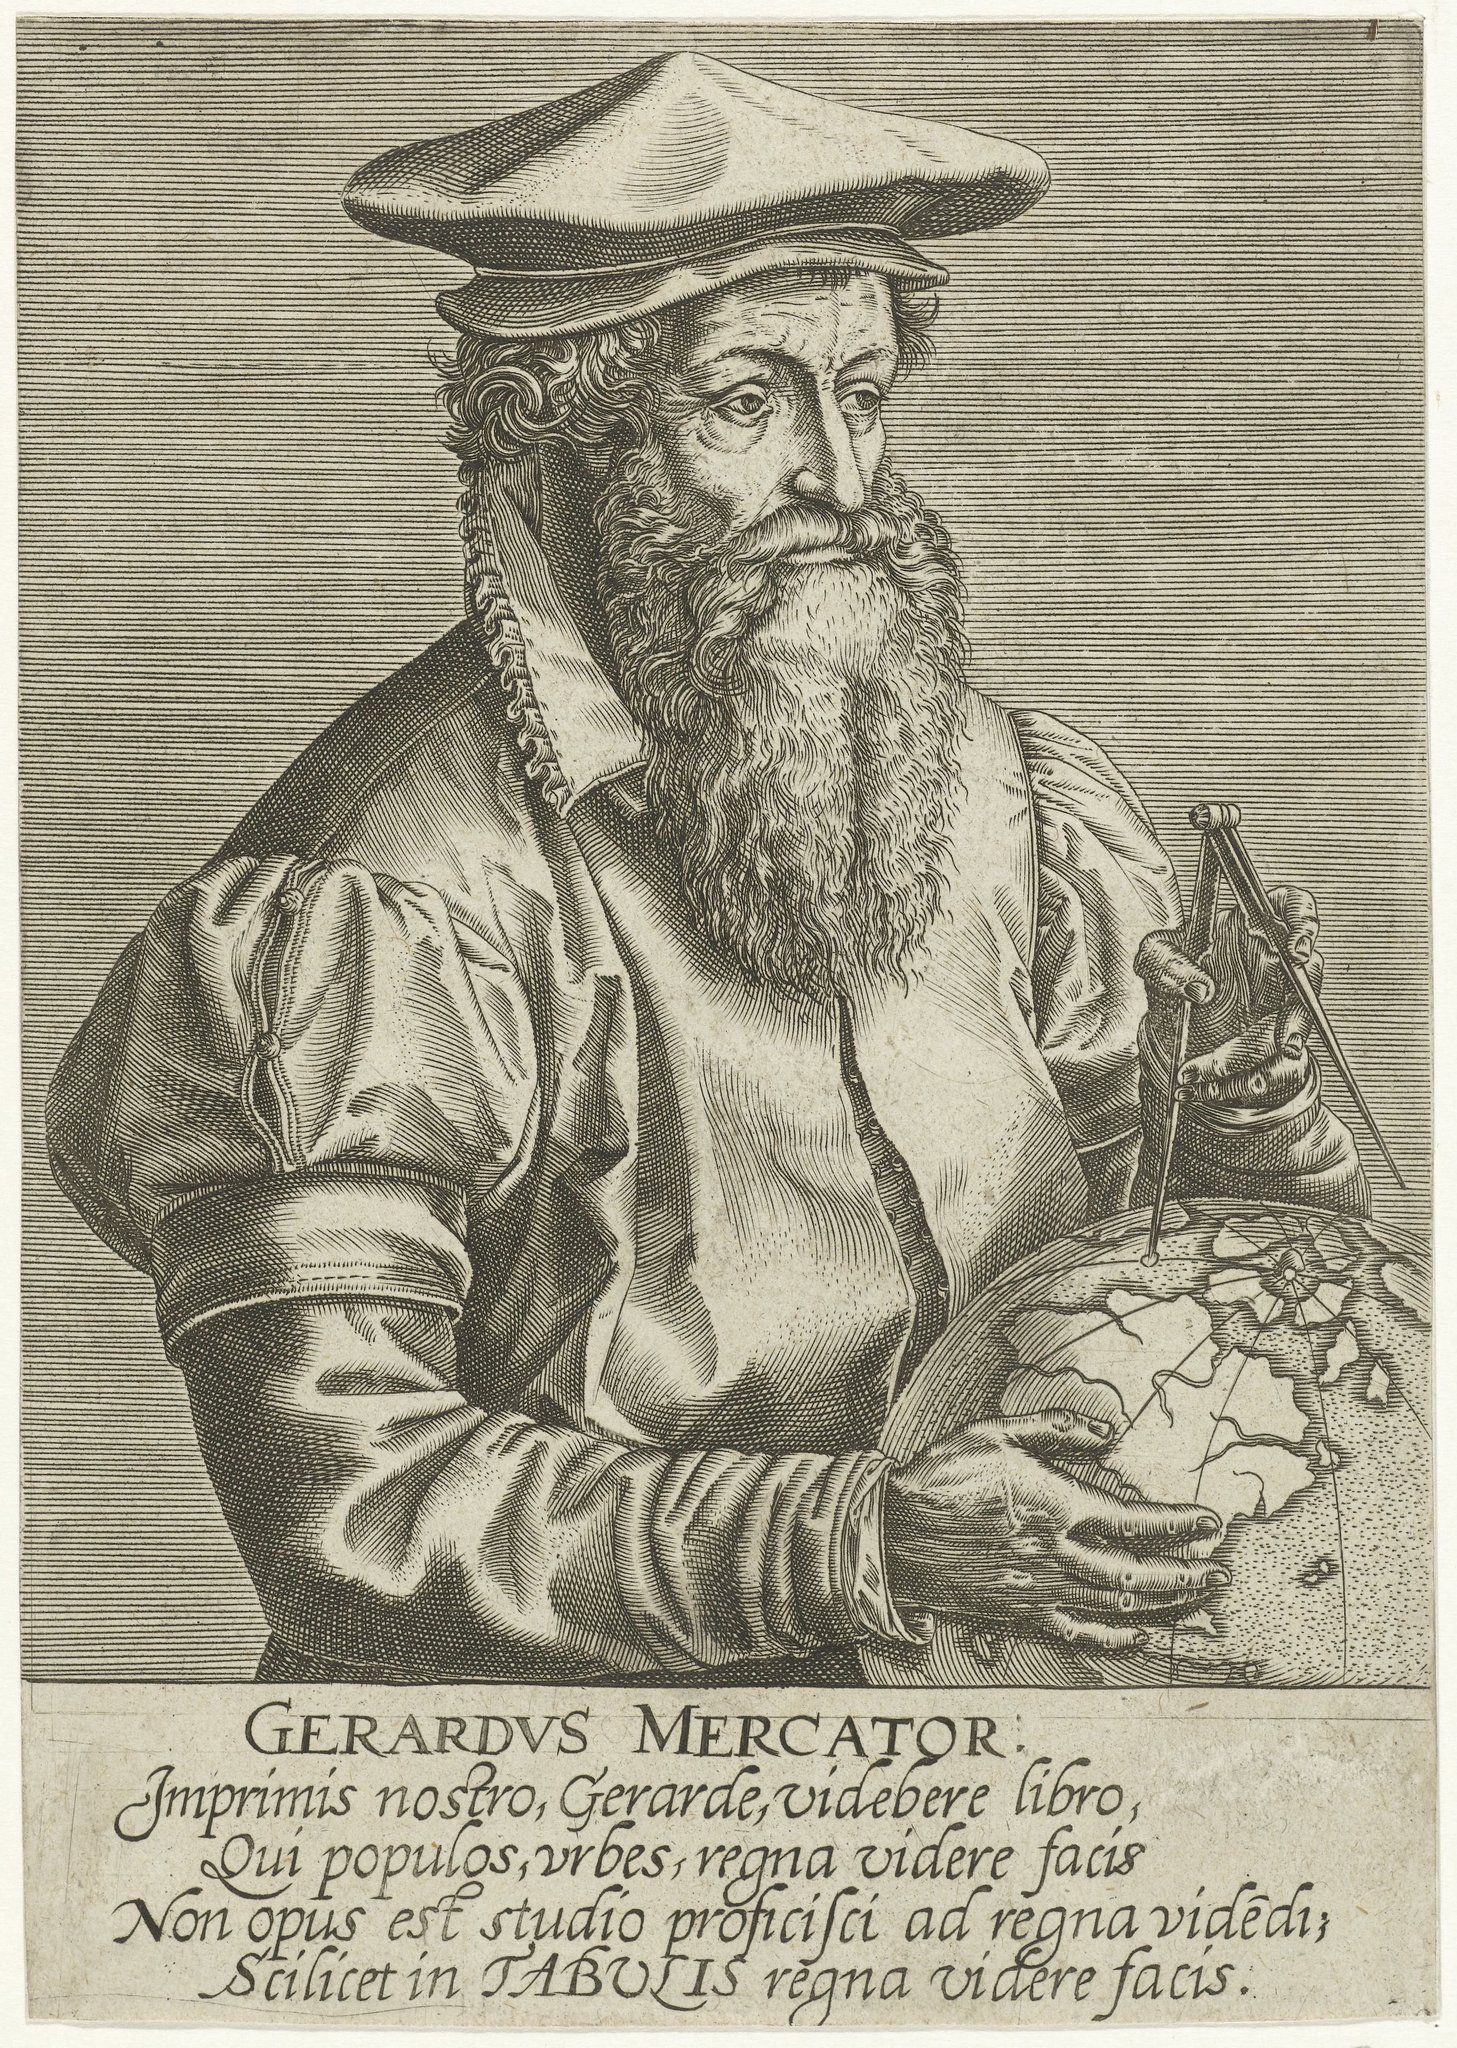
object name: print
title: Portret van Gerardus Mercator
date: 1587-1606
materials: paper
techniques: engraving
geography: antwerp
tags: gerardus mercator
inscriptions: collector's mark: Lugt 2228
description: Portret van Gerardus Mercator, beroemde cartograaf uit Rupelmonde. Buste naar rechts. In zijn handen een wereldglobe en een passer. De prent heeft een Latijns onderschrift en maakt deel uit van een serie van beroemde geleerden.